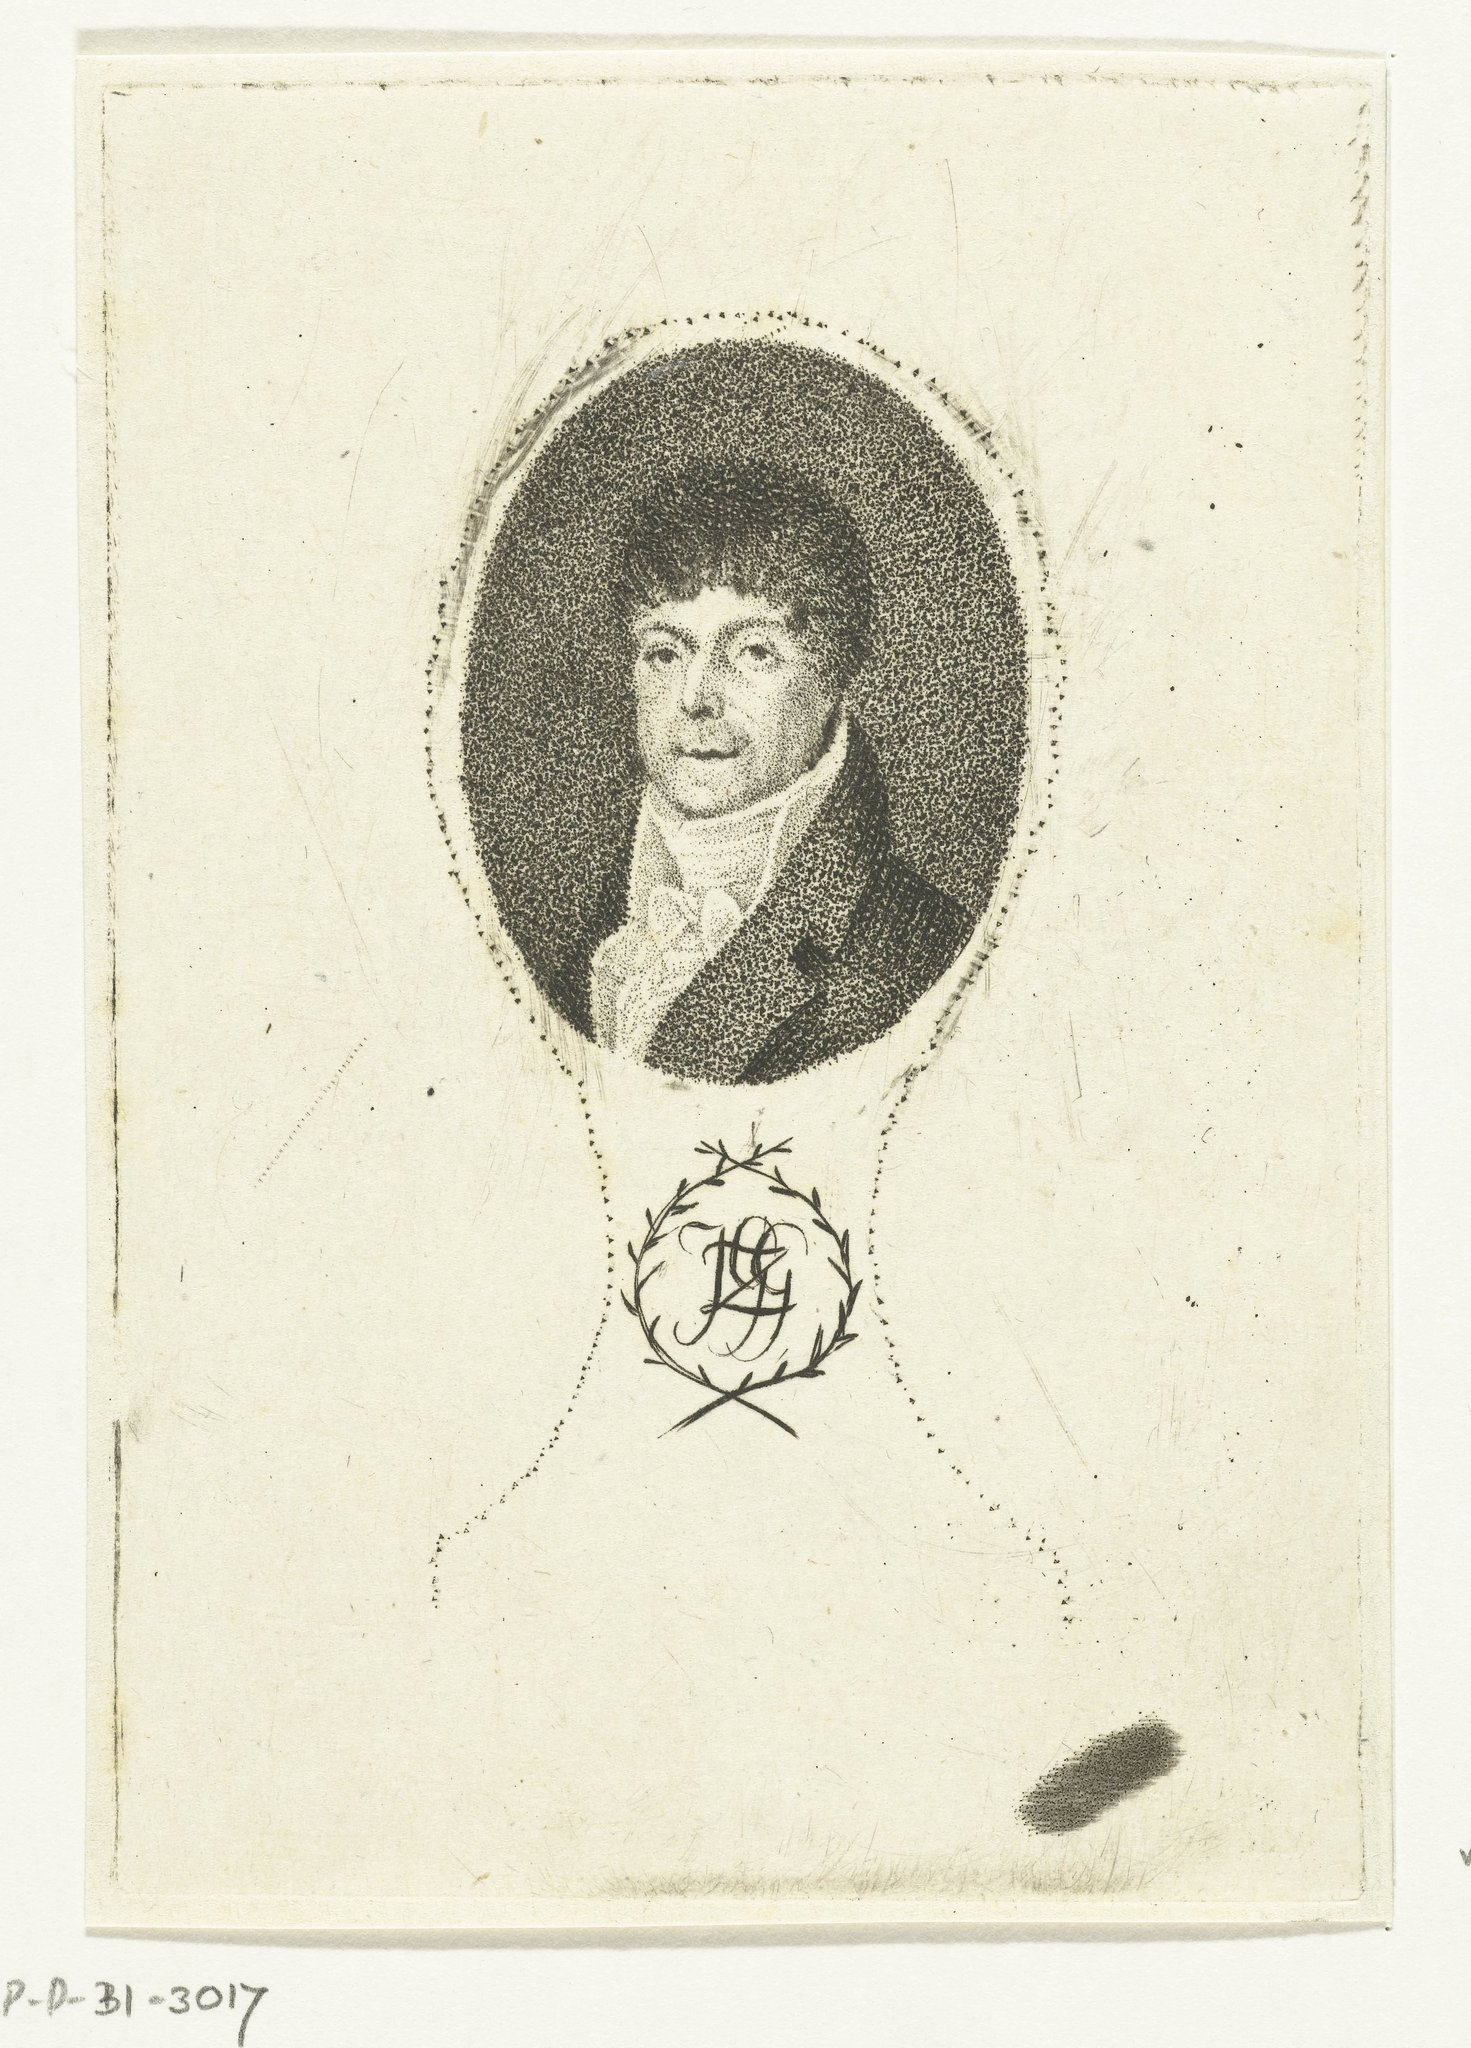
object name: print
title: Portret van J. Gazel, in ovaal met monogram JGGZ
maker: anthonie van den bos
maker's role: draughtsman, print maker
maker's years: 1763-1838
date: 1800-1838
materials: paper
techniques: engraving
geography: netherlands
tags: anonymous historical person portrayed alone (+ three-quarter view portrait)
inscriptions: collector's mark: Lugt 2228